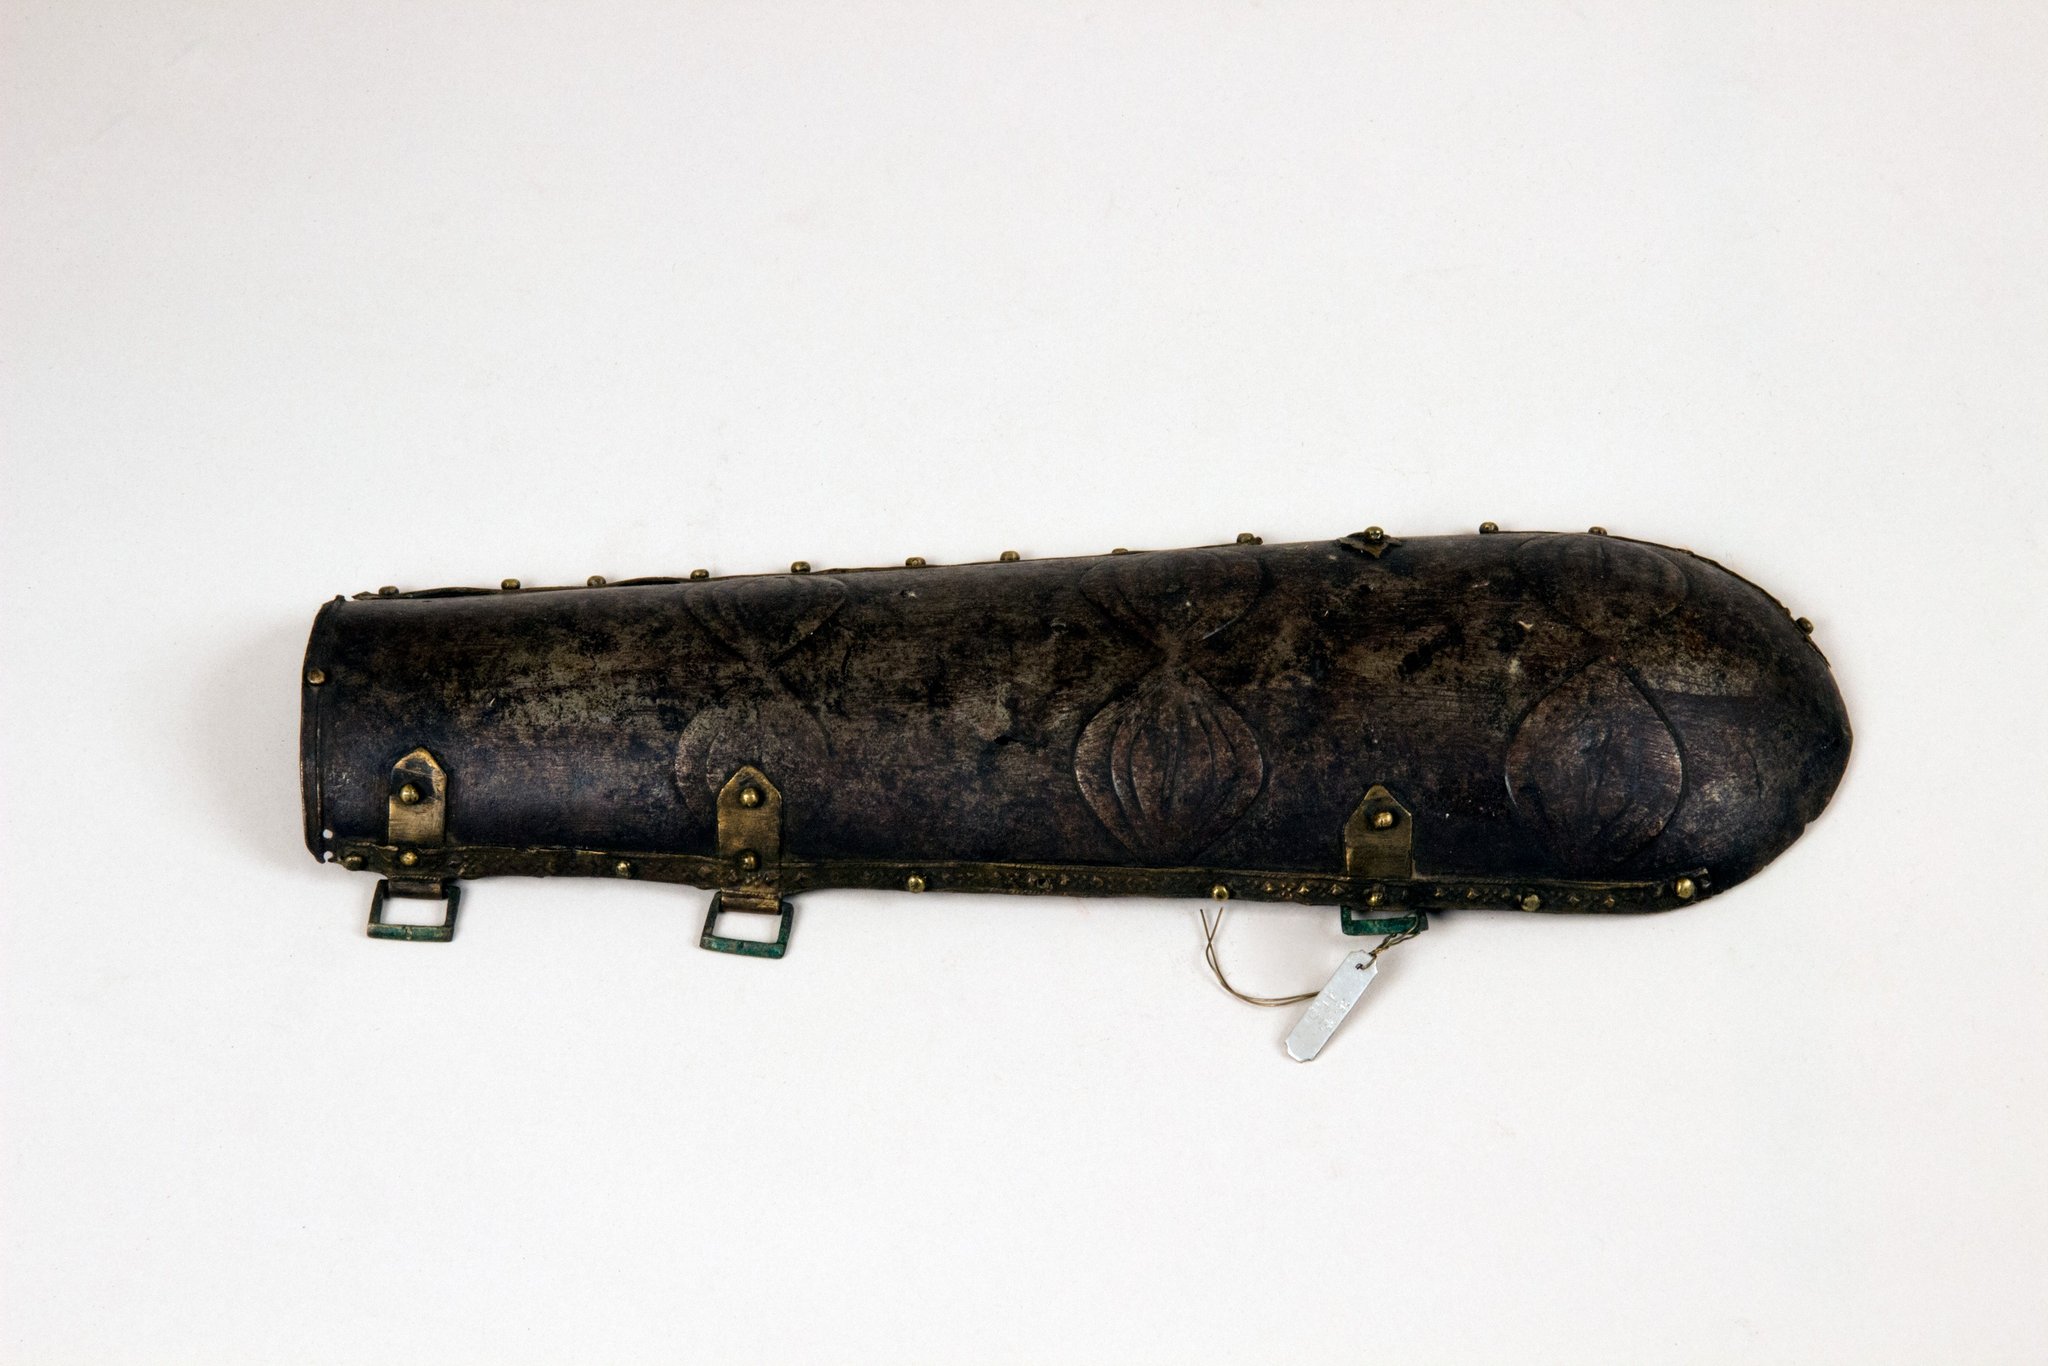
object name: arm guard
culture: turkish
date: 1701-1800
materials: brass, steel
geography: ottoman empire